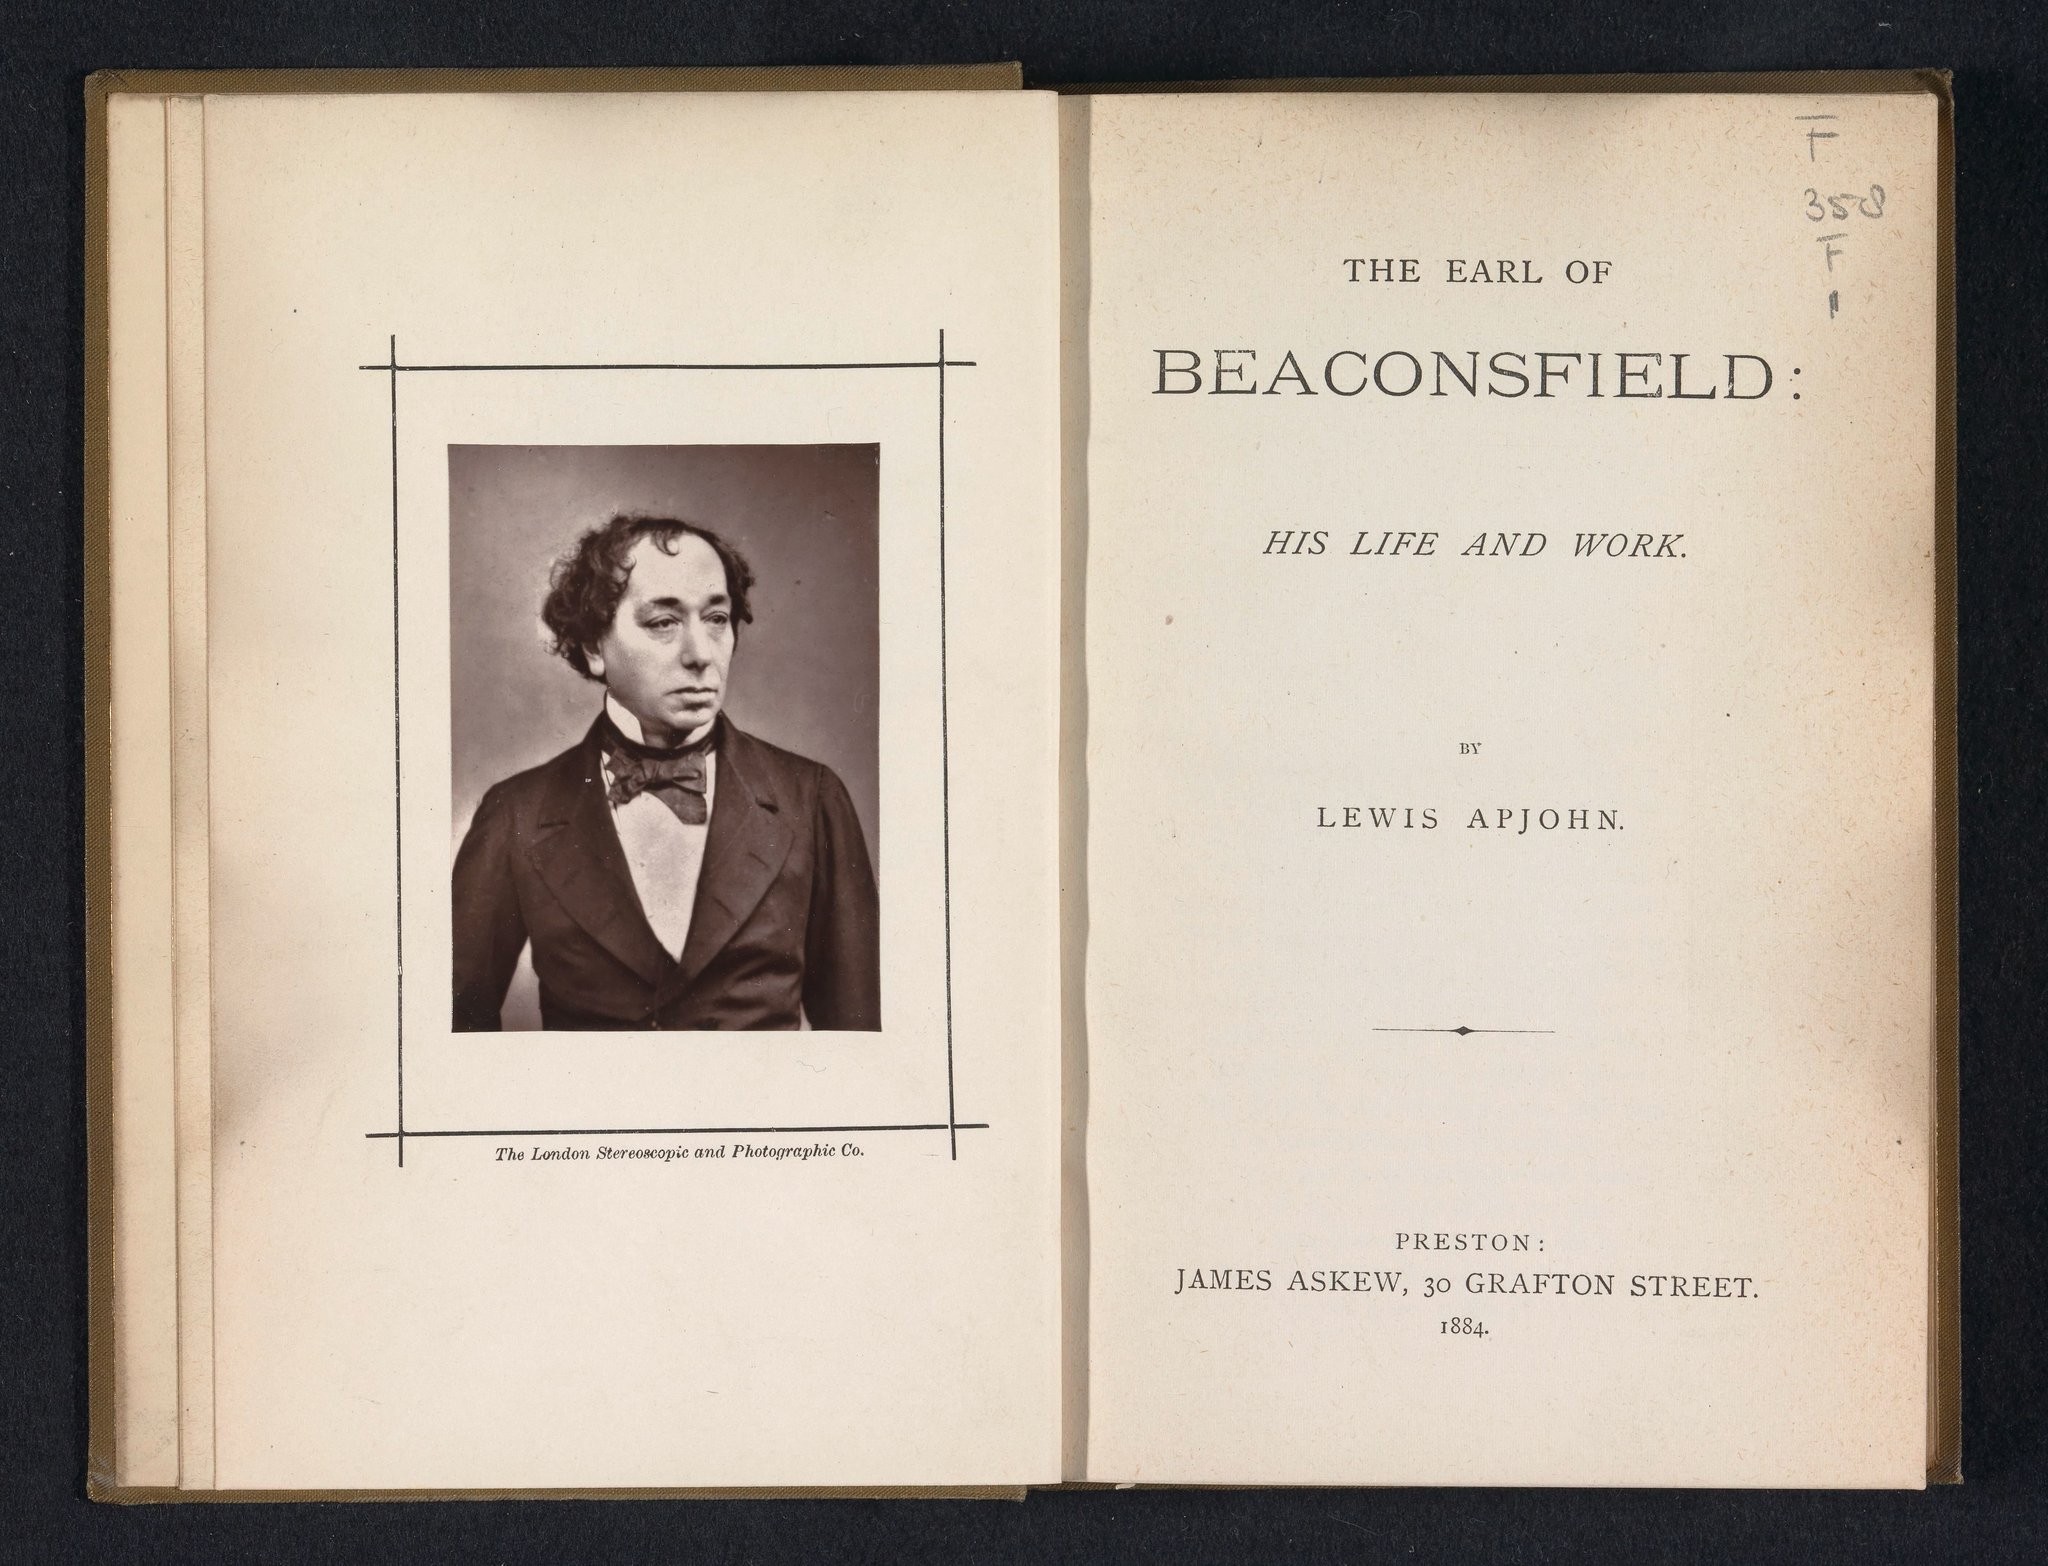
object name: page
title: Portret van Benjamin Disraeli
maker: Anonymous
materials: paper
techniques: woodburytype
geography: london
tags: adult man